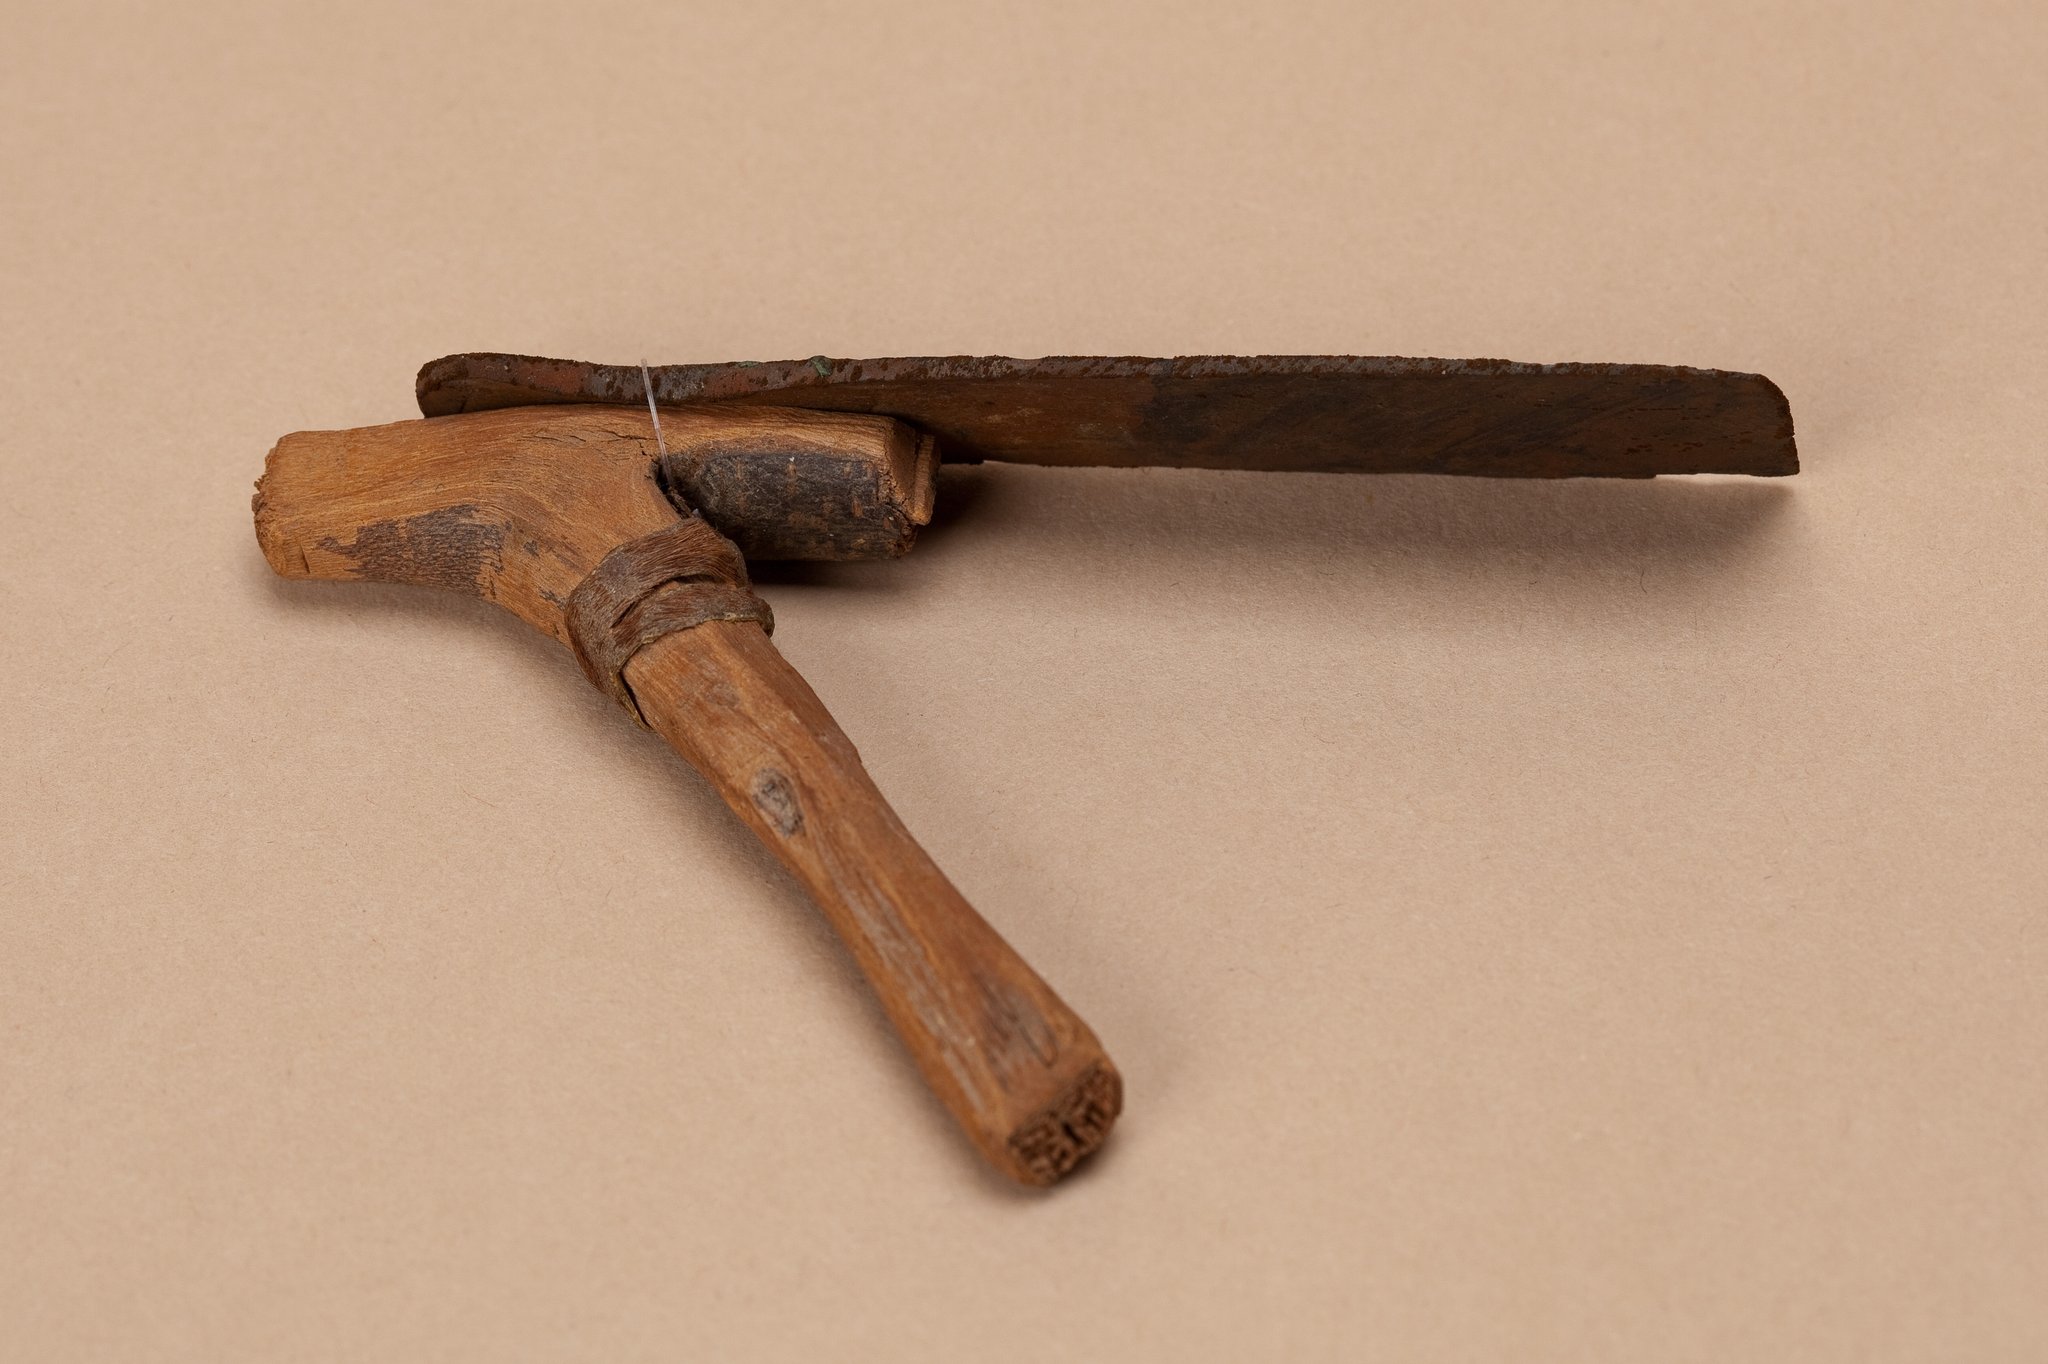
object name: model adze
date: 1981-1802 BCE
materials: copper, wood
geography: egypt